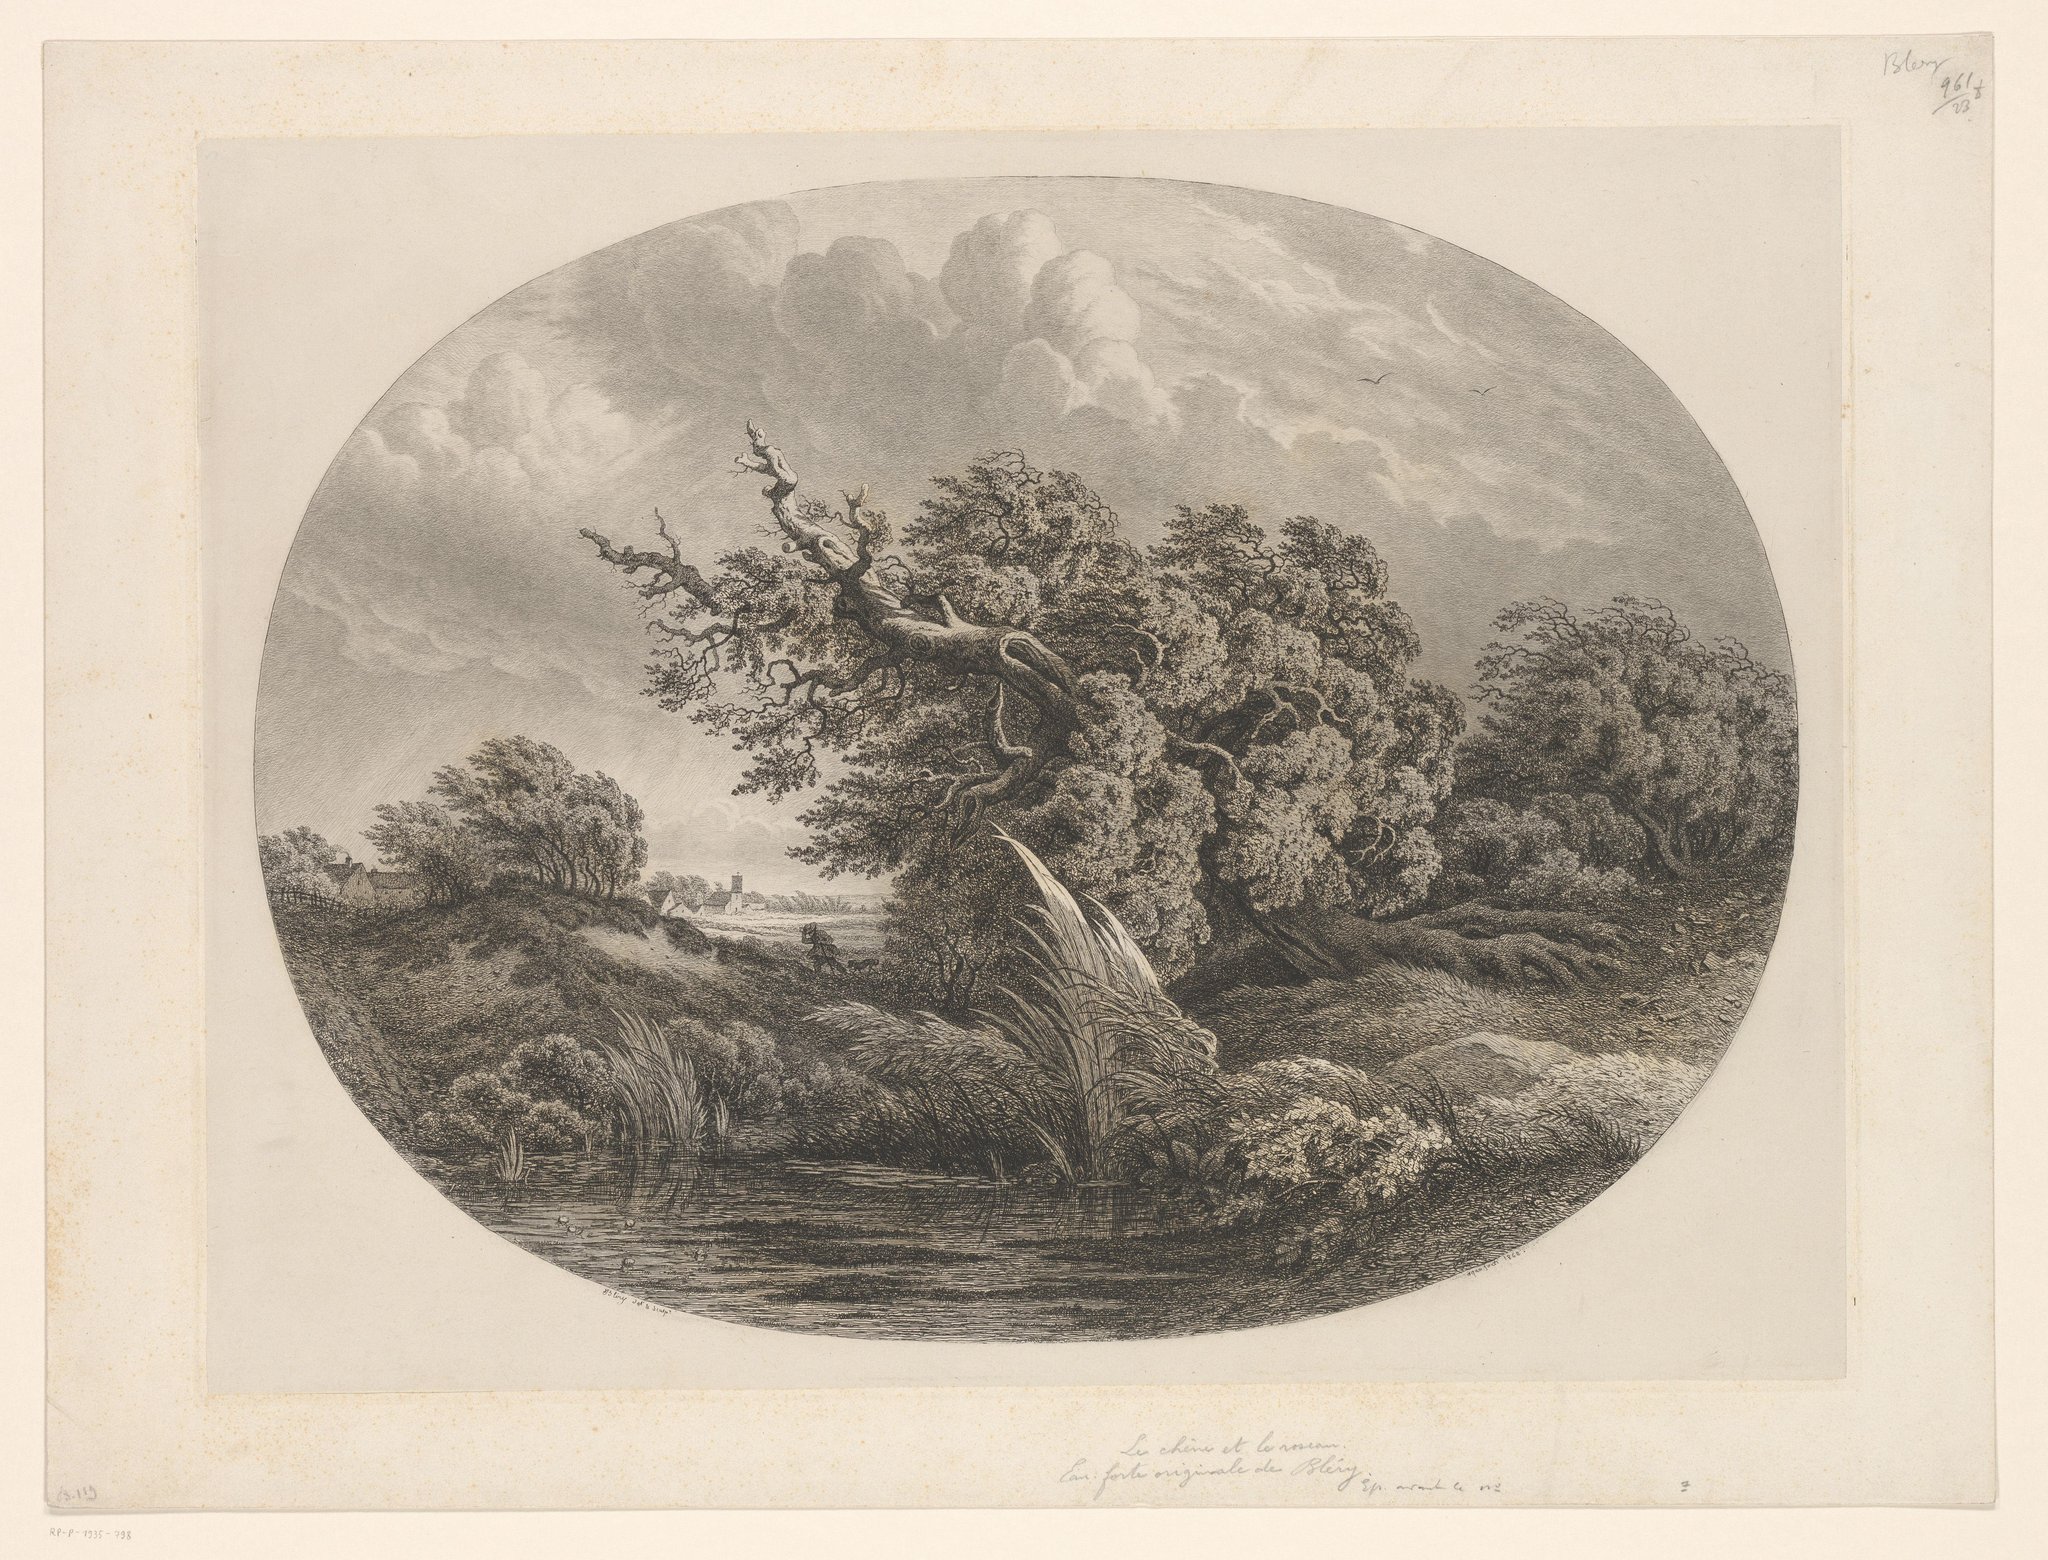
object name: print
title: Poel met scheefgezakte boom en wandelaar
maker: eugène bléry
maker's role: print maker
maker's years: 1805-1887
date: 1862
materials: paper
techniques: engraving, etching, roulette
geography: france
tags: trees: oak, winds, pond, pool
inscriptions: collector's mark: Lugt 2228